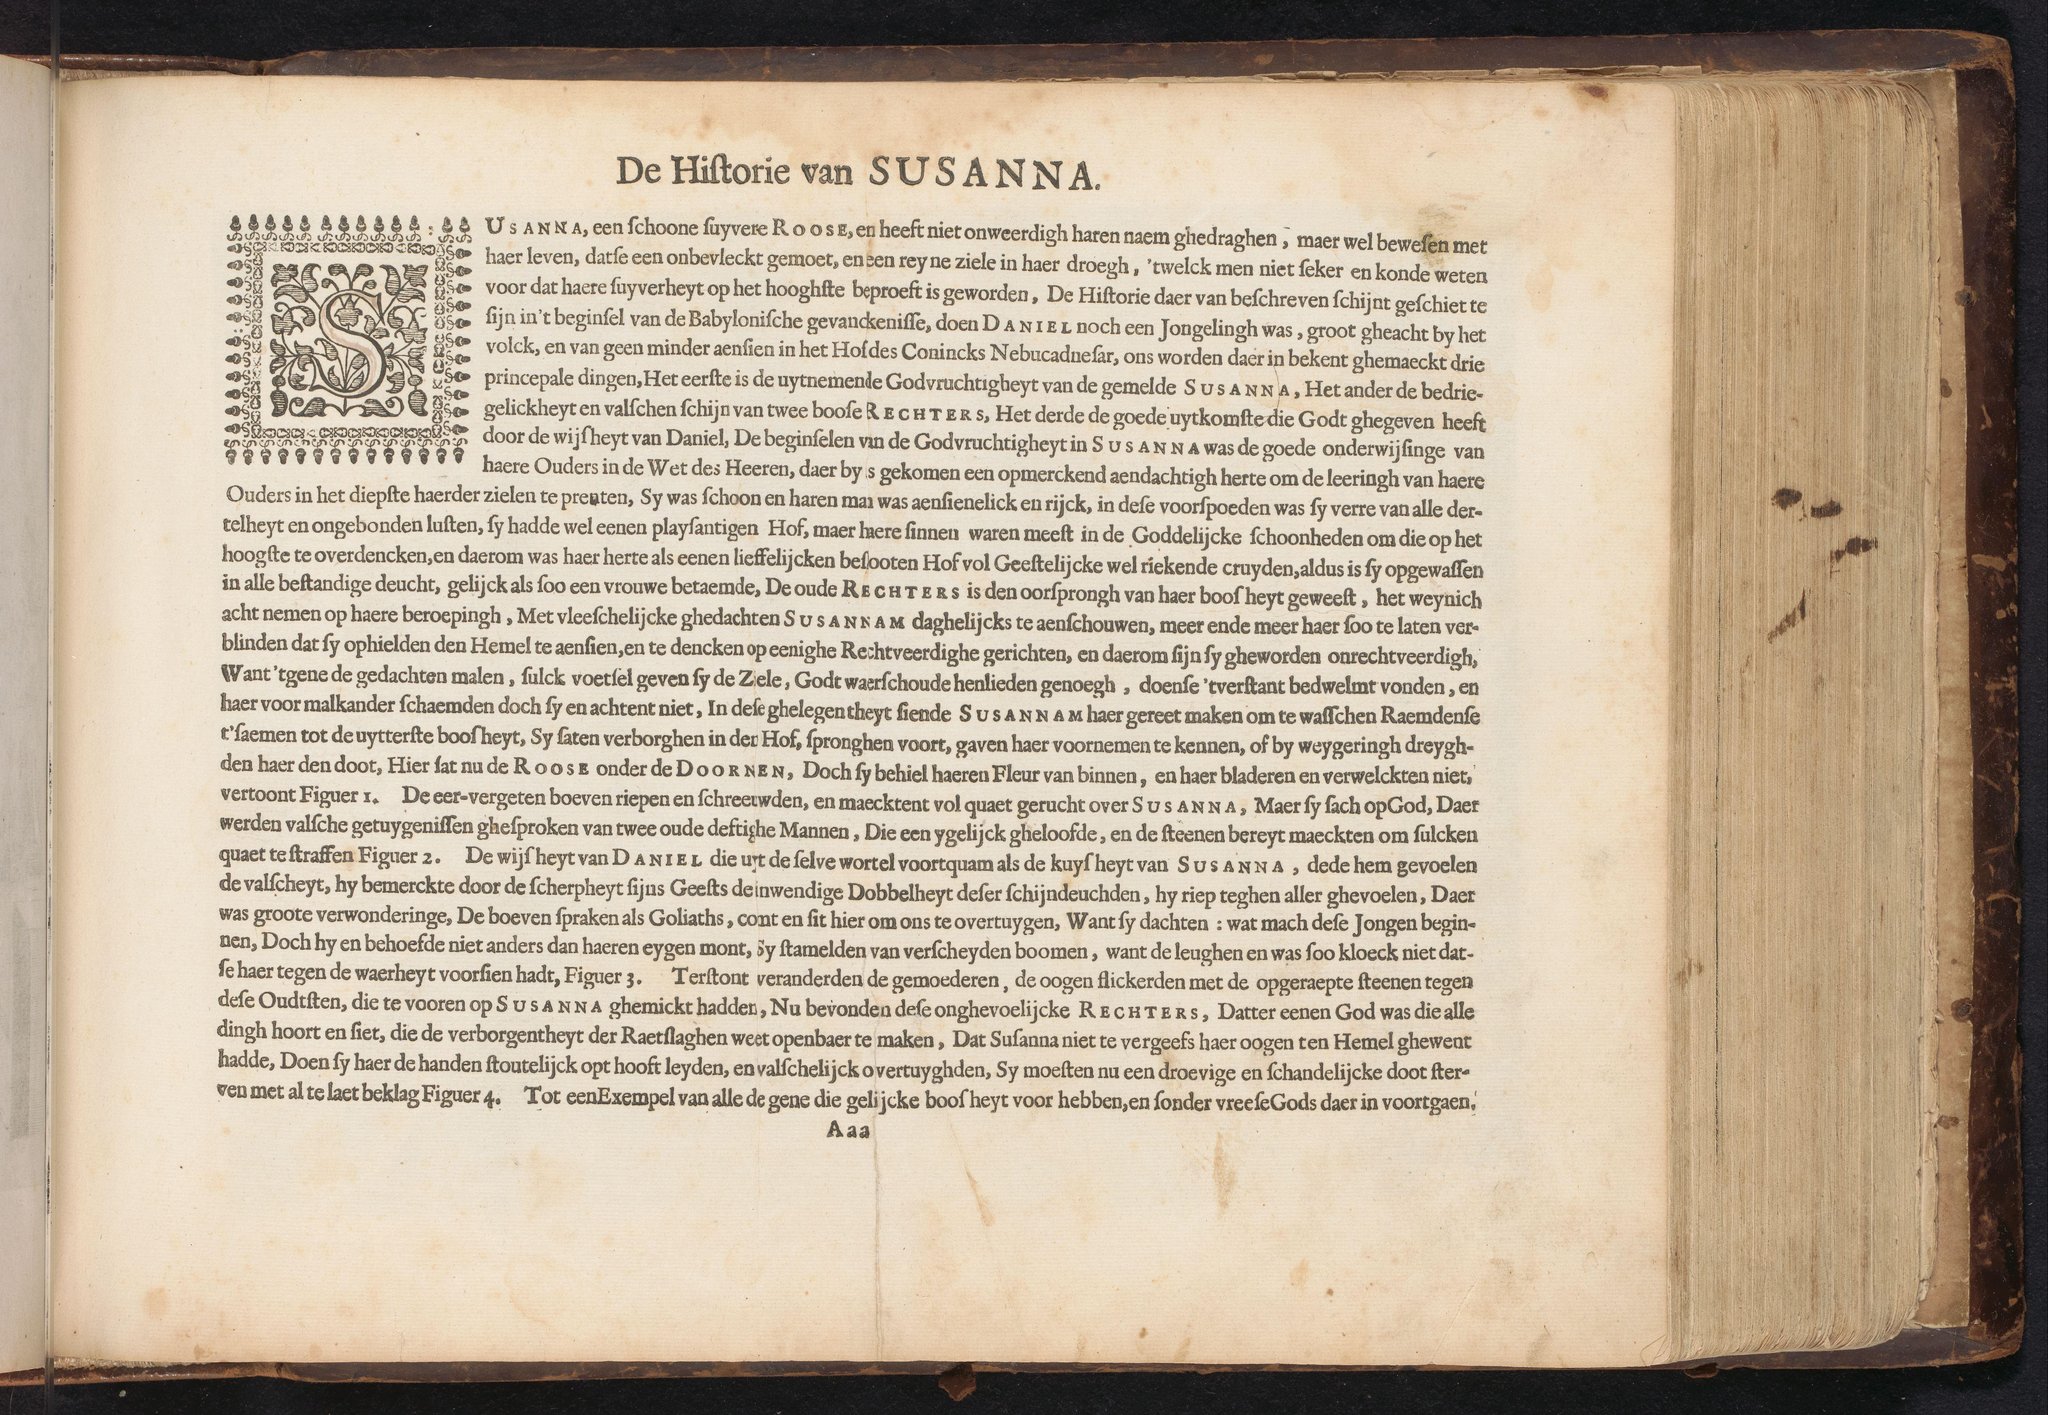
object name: text sheet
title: De Historie van Susanna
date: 1646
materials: paper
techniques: hand coloring, letterpress printing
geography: alkmaar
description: Tekstblad bij een serie prenten over de geschiedenis van Susanna. Linksboven initiaal S. Dit blad maakt deel uit van een album.